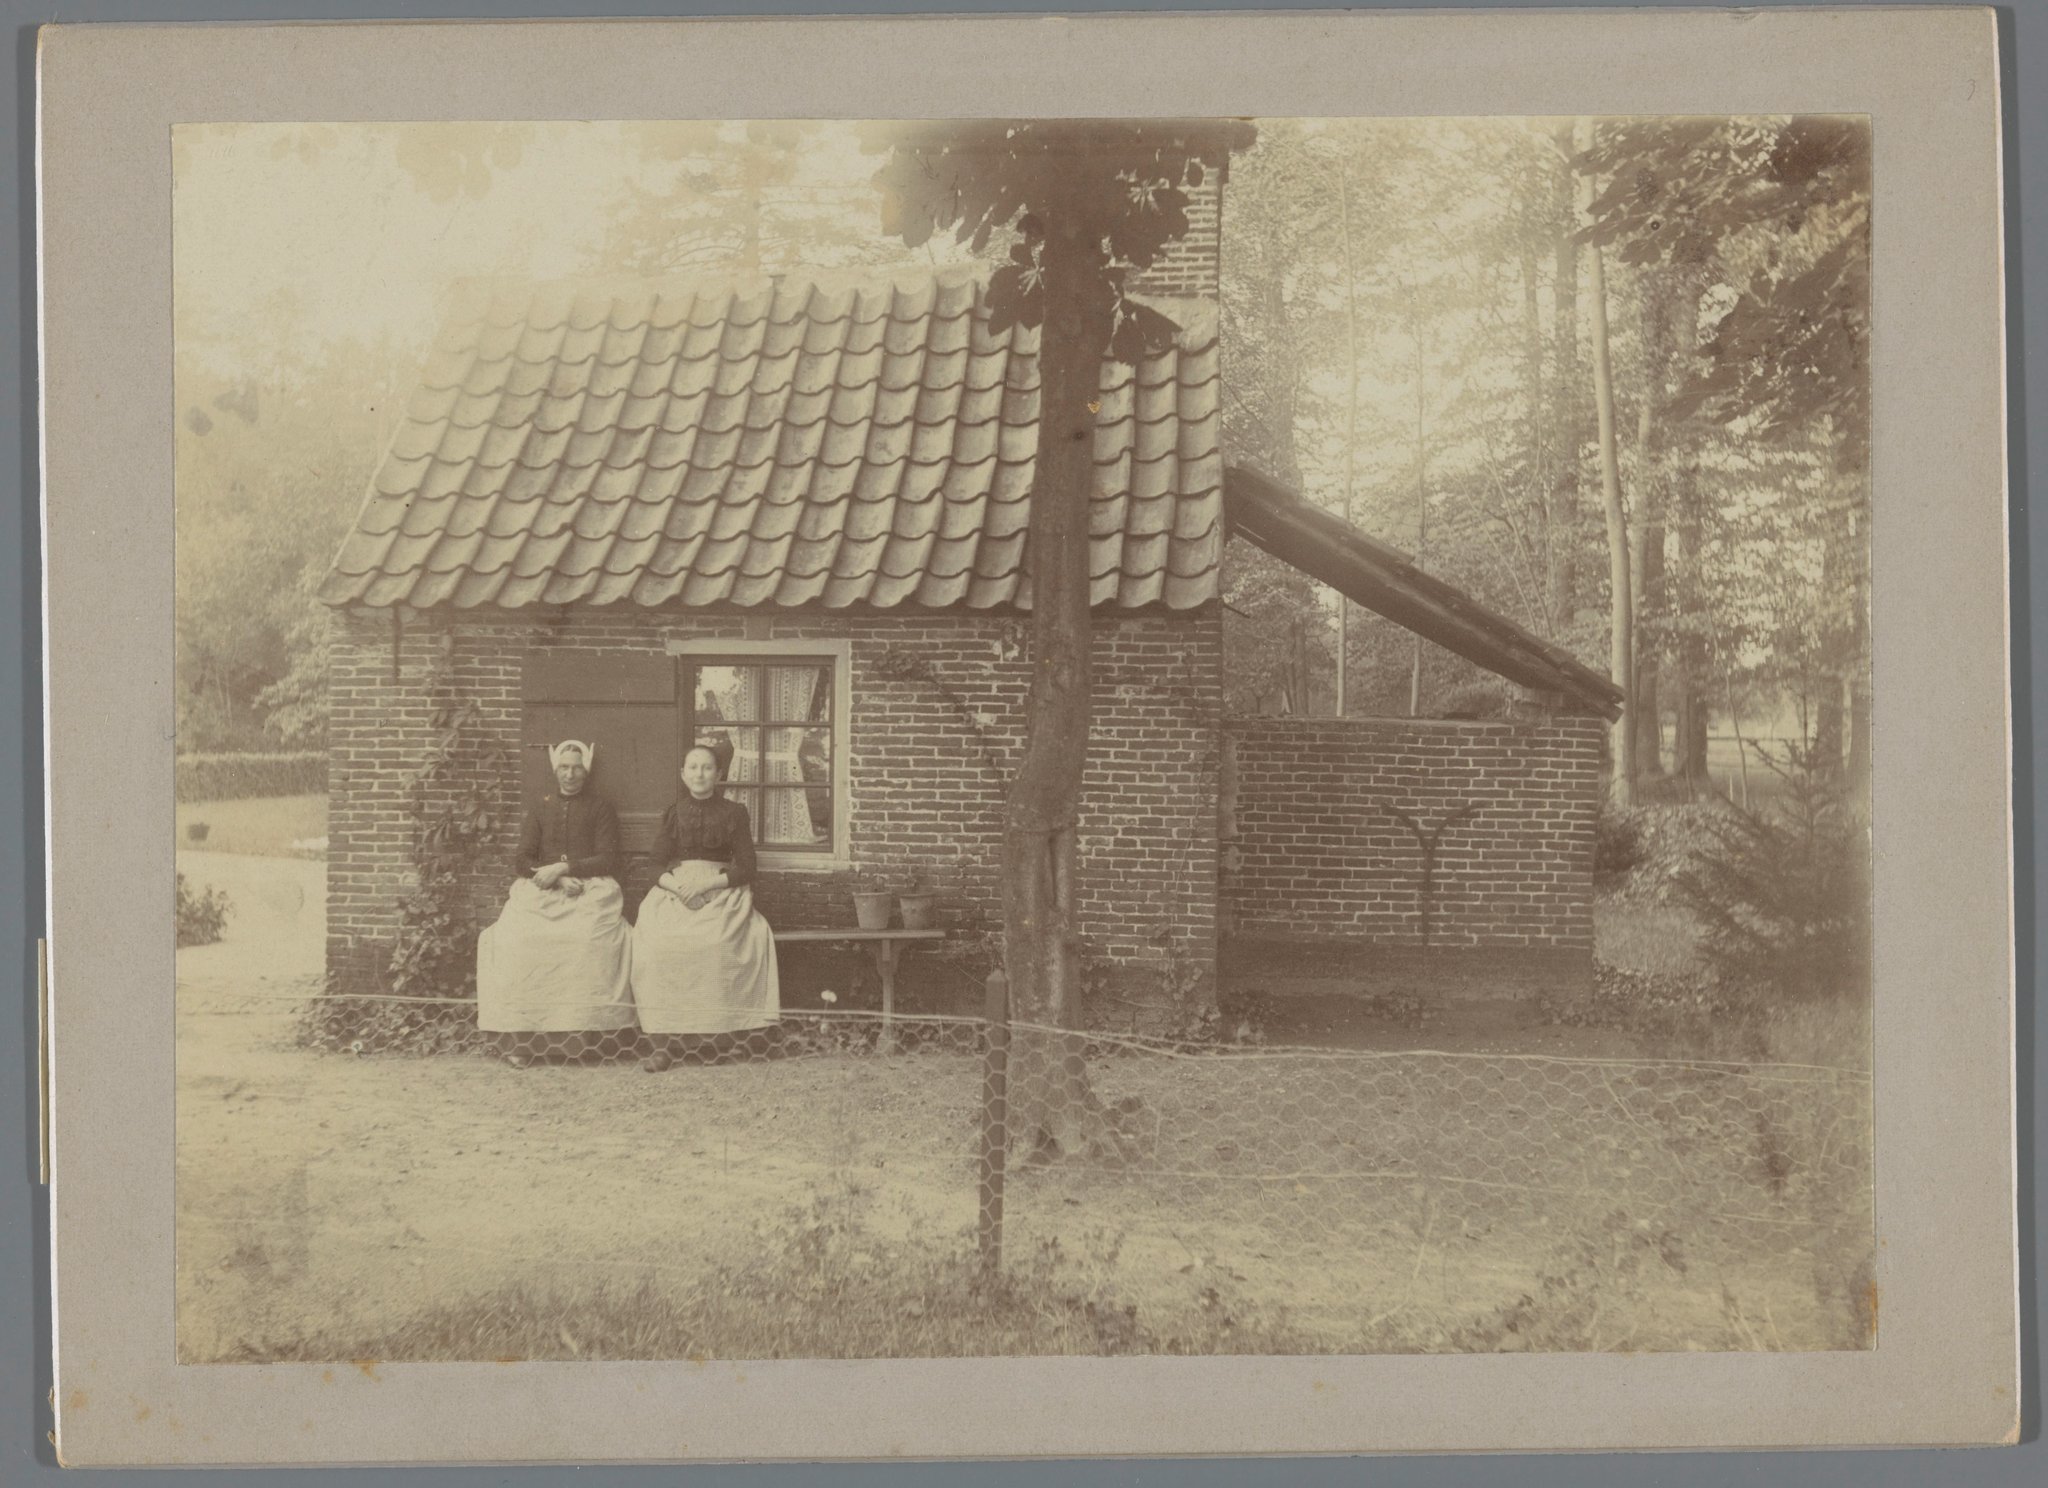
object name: photograph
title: Portret van twee onbekende vrouwen bij een tuinhuisje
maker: cornelia hendrika jonker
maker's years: 1874-1924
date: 1896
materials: cardboard, photographic support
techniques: collodion silver print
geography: maartensdijk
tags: garden, historical persons, gardening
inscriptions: annotation: ‘Maartensdijk/ vrouw van de tuinman met hulp/ C.J. Augustus 1896’